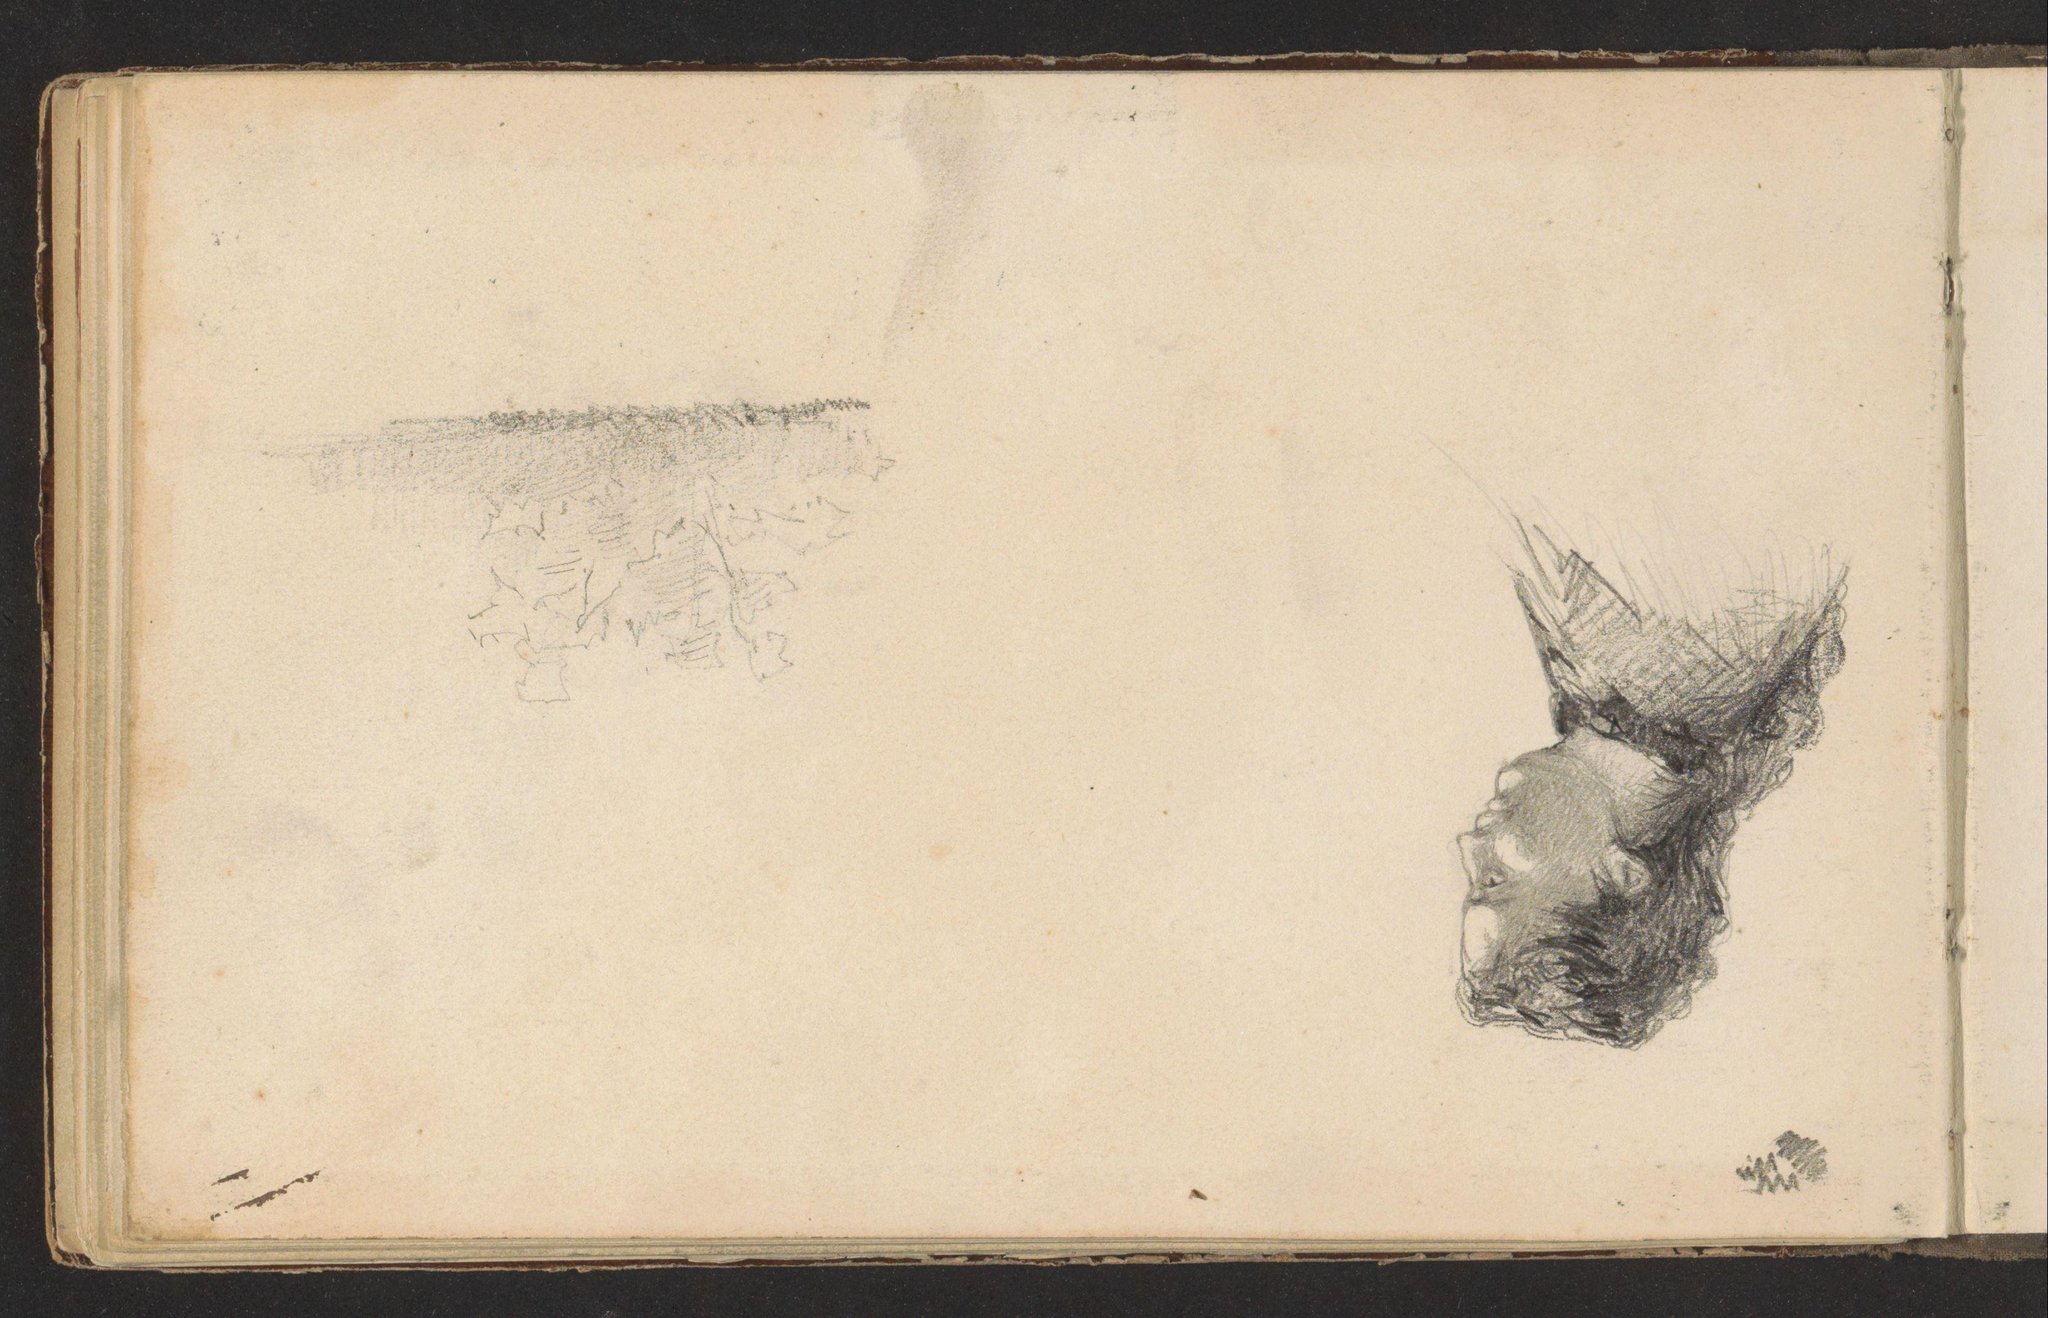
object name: sketchbook leaf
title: Struiken en een vrouwenportret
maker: maria vos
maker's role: draughtsman, painter, print maker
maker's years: 1824-1906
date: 1871-1878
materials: paper, pencil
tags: head (human) (+ female (human being) (not to be used where -aa- is prescribed)), shrubs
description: Blad 45 verso uit een schetsboek met 45 bladen.